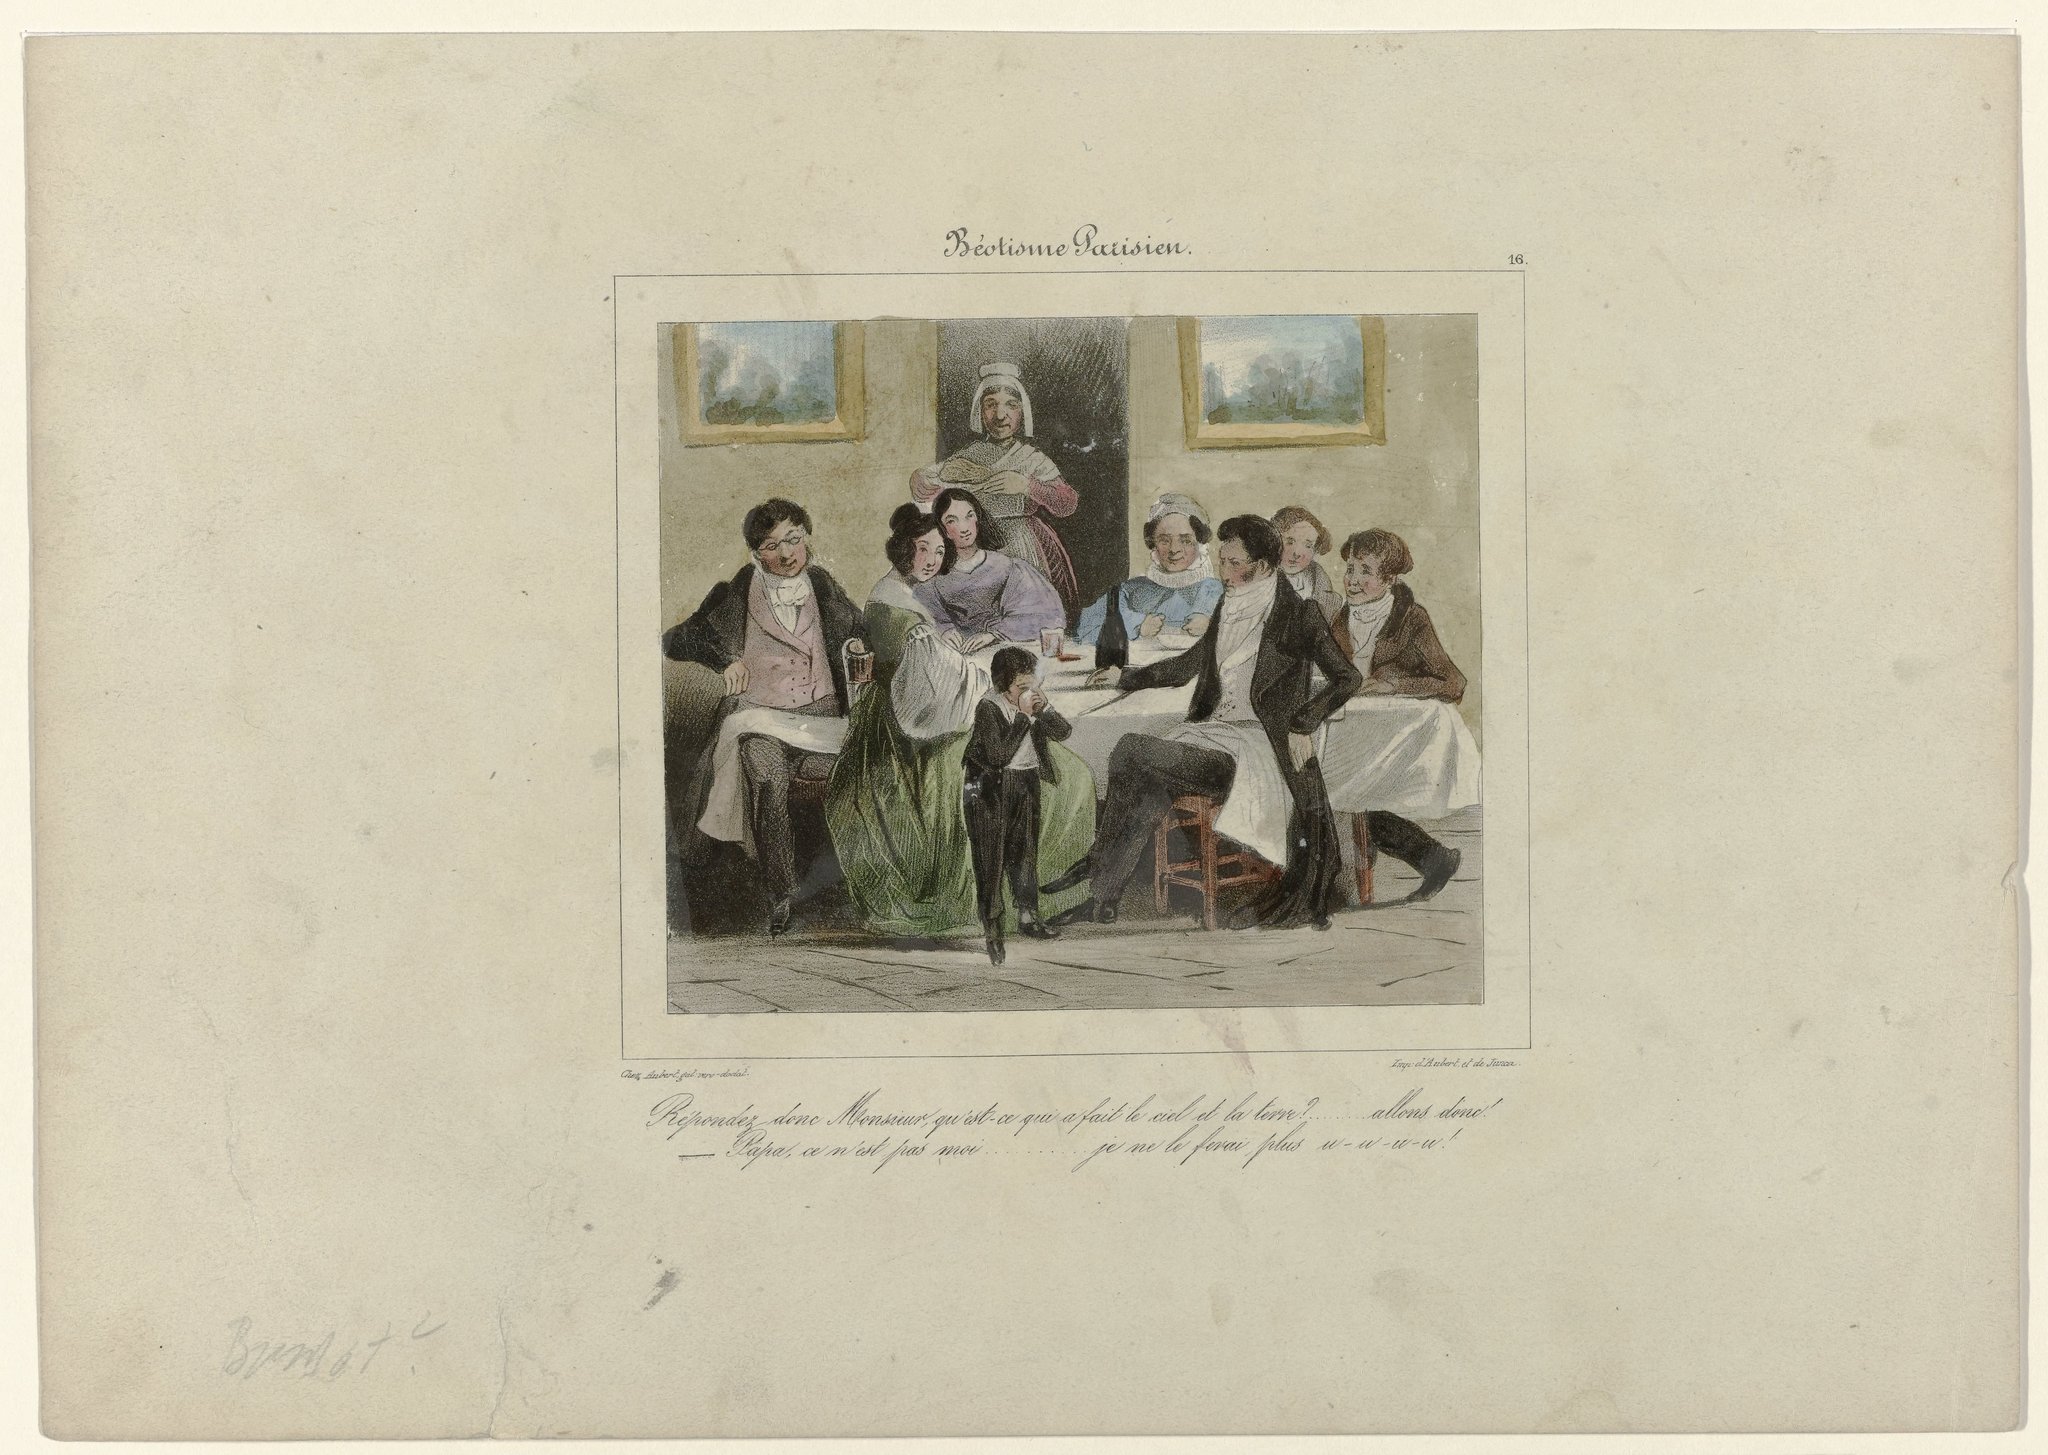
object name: print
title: Béotisme Parisien, No. 16, ca. 1835-1837 : Répondes donc Monsieur (...)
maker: Anonymous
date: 1835-1837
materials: paper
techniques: hand coloring, lithograph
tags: dinner-service (+ serving, servants at table, meal), crying, shouting (+ young male (human being)), clothes, costume (+ women's clothes), clothes, costume (+ men's clothes)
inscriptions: title: ‘Béotisme Parisien.’, caption: ‘Répondes donc Monsieur, qu'est-ce qui a fait le ciel et la terre?...... allons donc!_Papa, ce n'est pas moi... je ne le ferai, plus u-u-u-u!’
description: Gezelschap aan gedekte tafel. Een man kijkt boos naar een huilende jongen. Met tweeregelig Frans onderschift. De prent maakt deel uit van een satirische serie getiteld 'Béotisme Parisien', uitgegeven door Aubert.